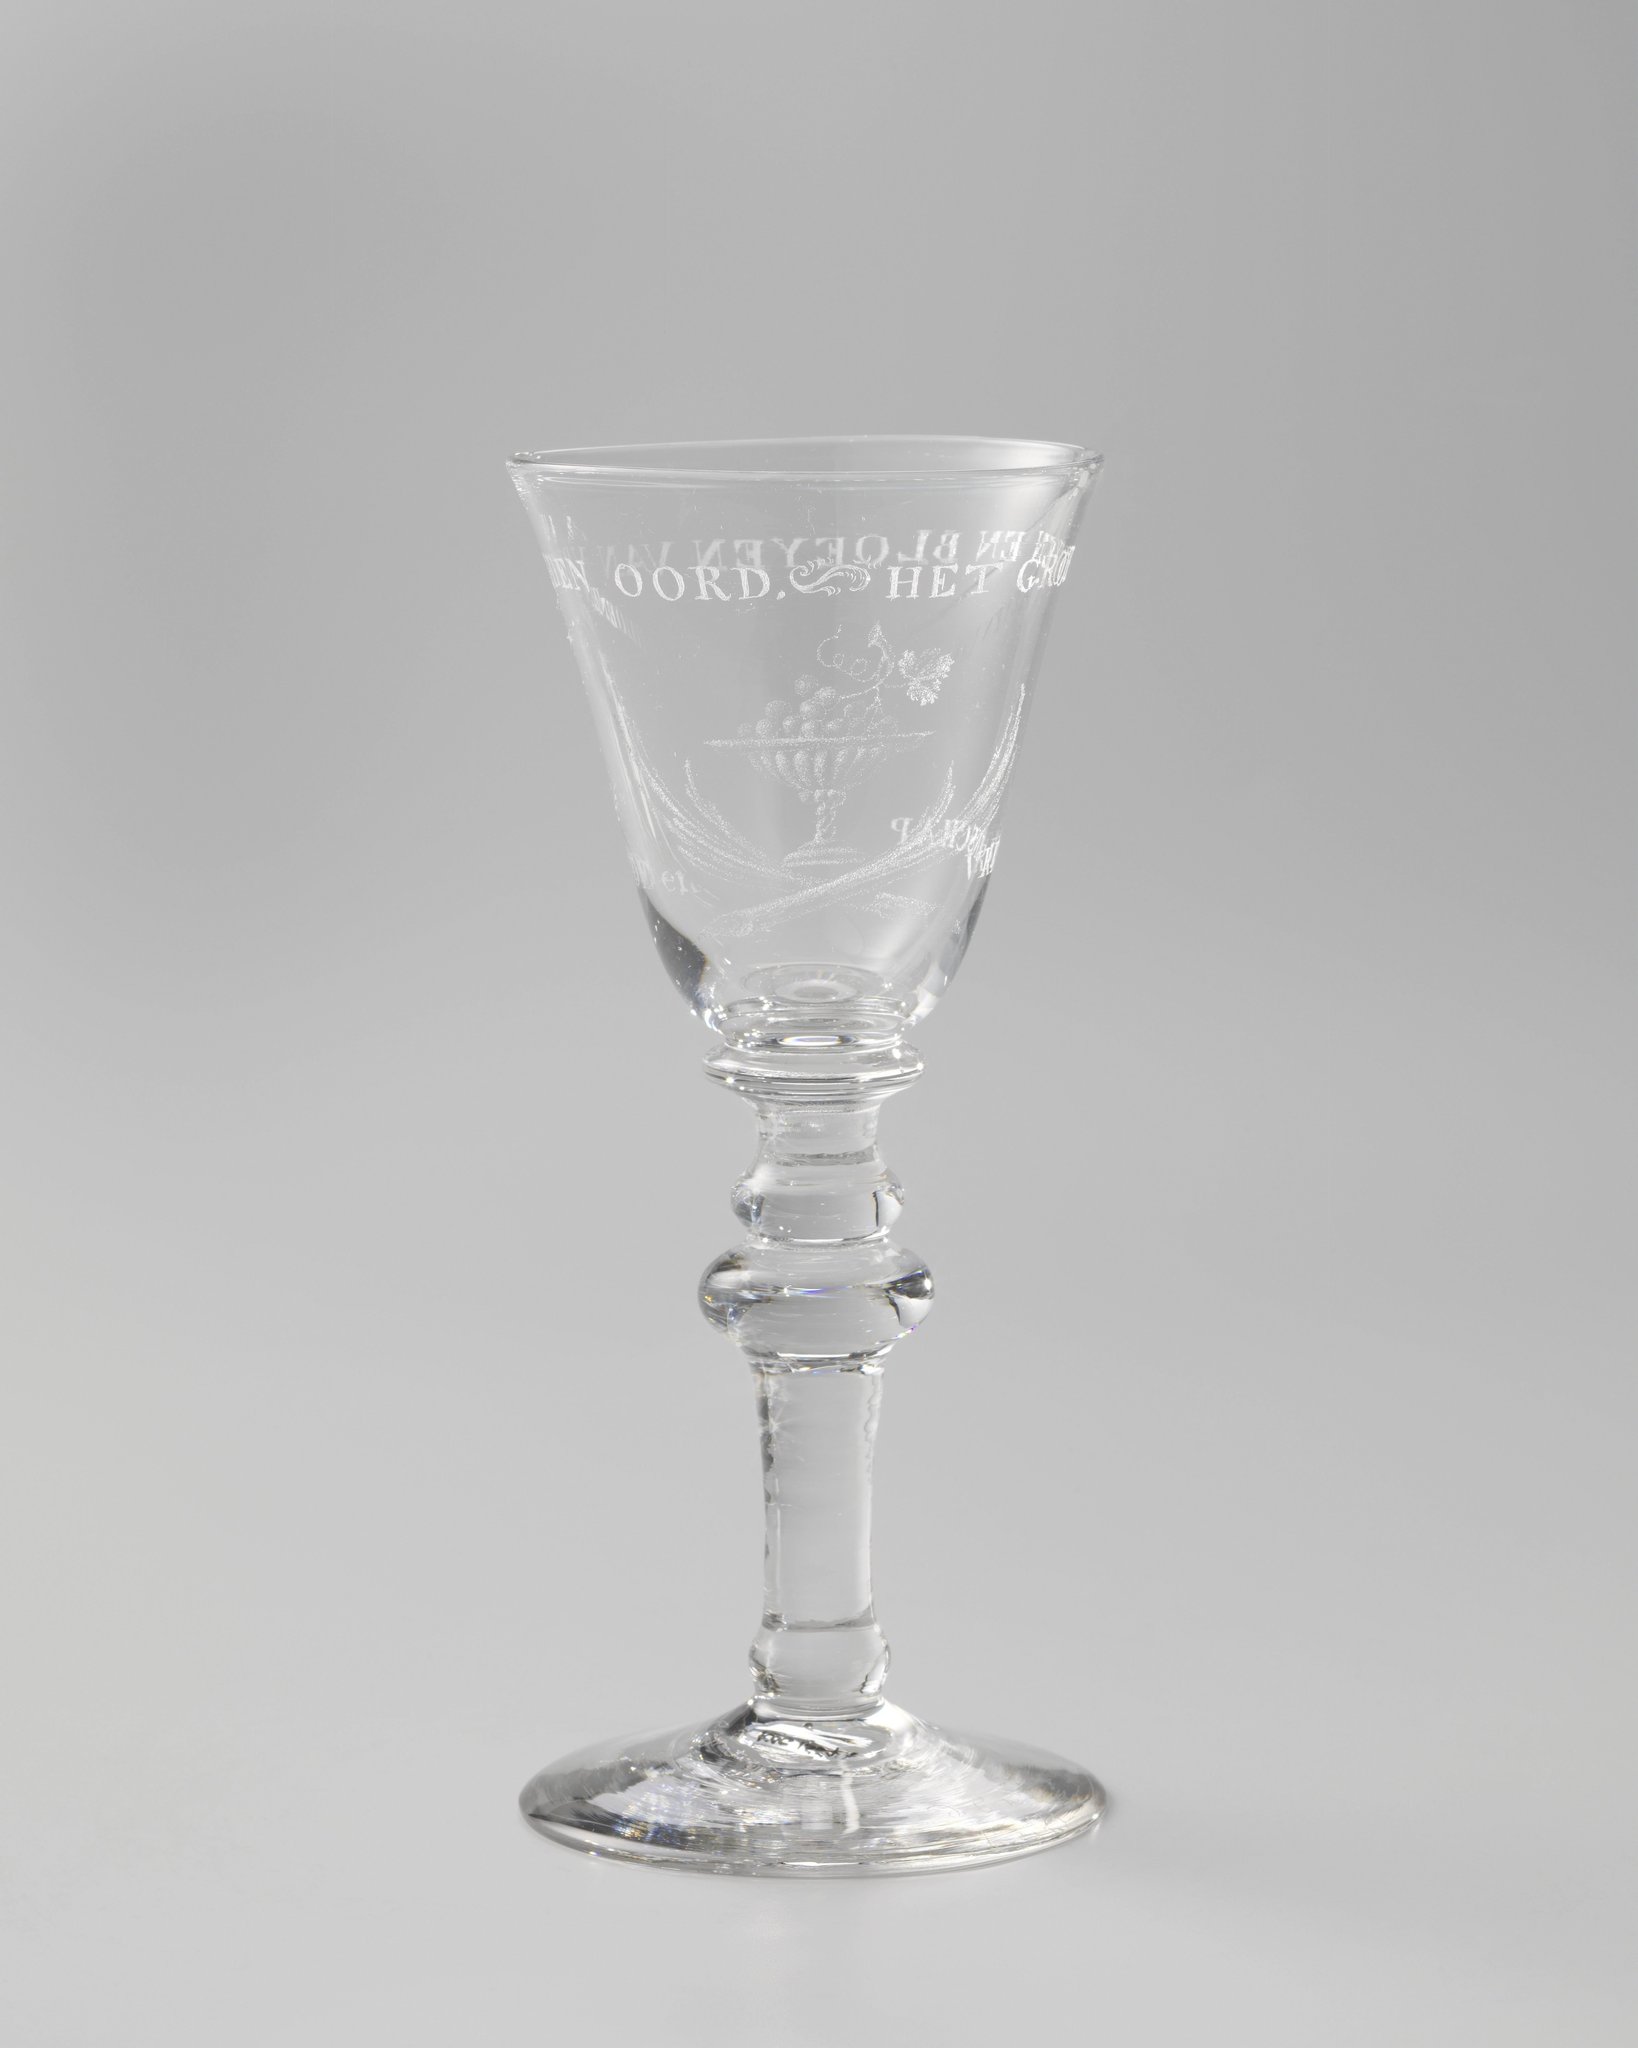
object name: goblet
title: Wine glass with a dish of grapes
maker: pieter luyten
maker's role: draughtsman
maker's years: 1770-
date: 1799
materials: glass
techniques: glassblowing, engraving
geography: dordrecht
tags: bunch of grapes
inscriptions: inscription: ‘HET GROEYEN EN BLOEYEN VAN VREEDEN OORD.’, signature: ‘Pr. Luyten fecit 1799’, inscription: ‘VREEDE en VRIENSCHAP’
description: translation of inscription: the growth and prosperity of Vreeden Oord / Peace and Friendship